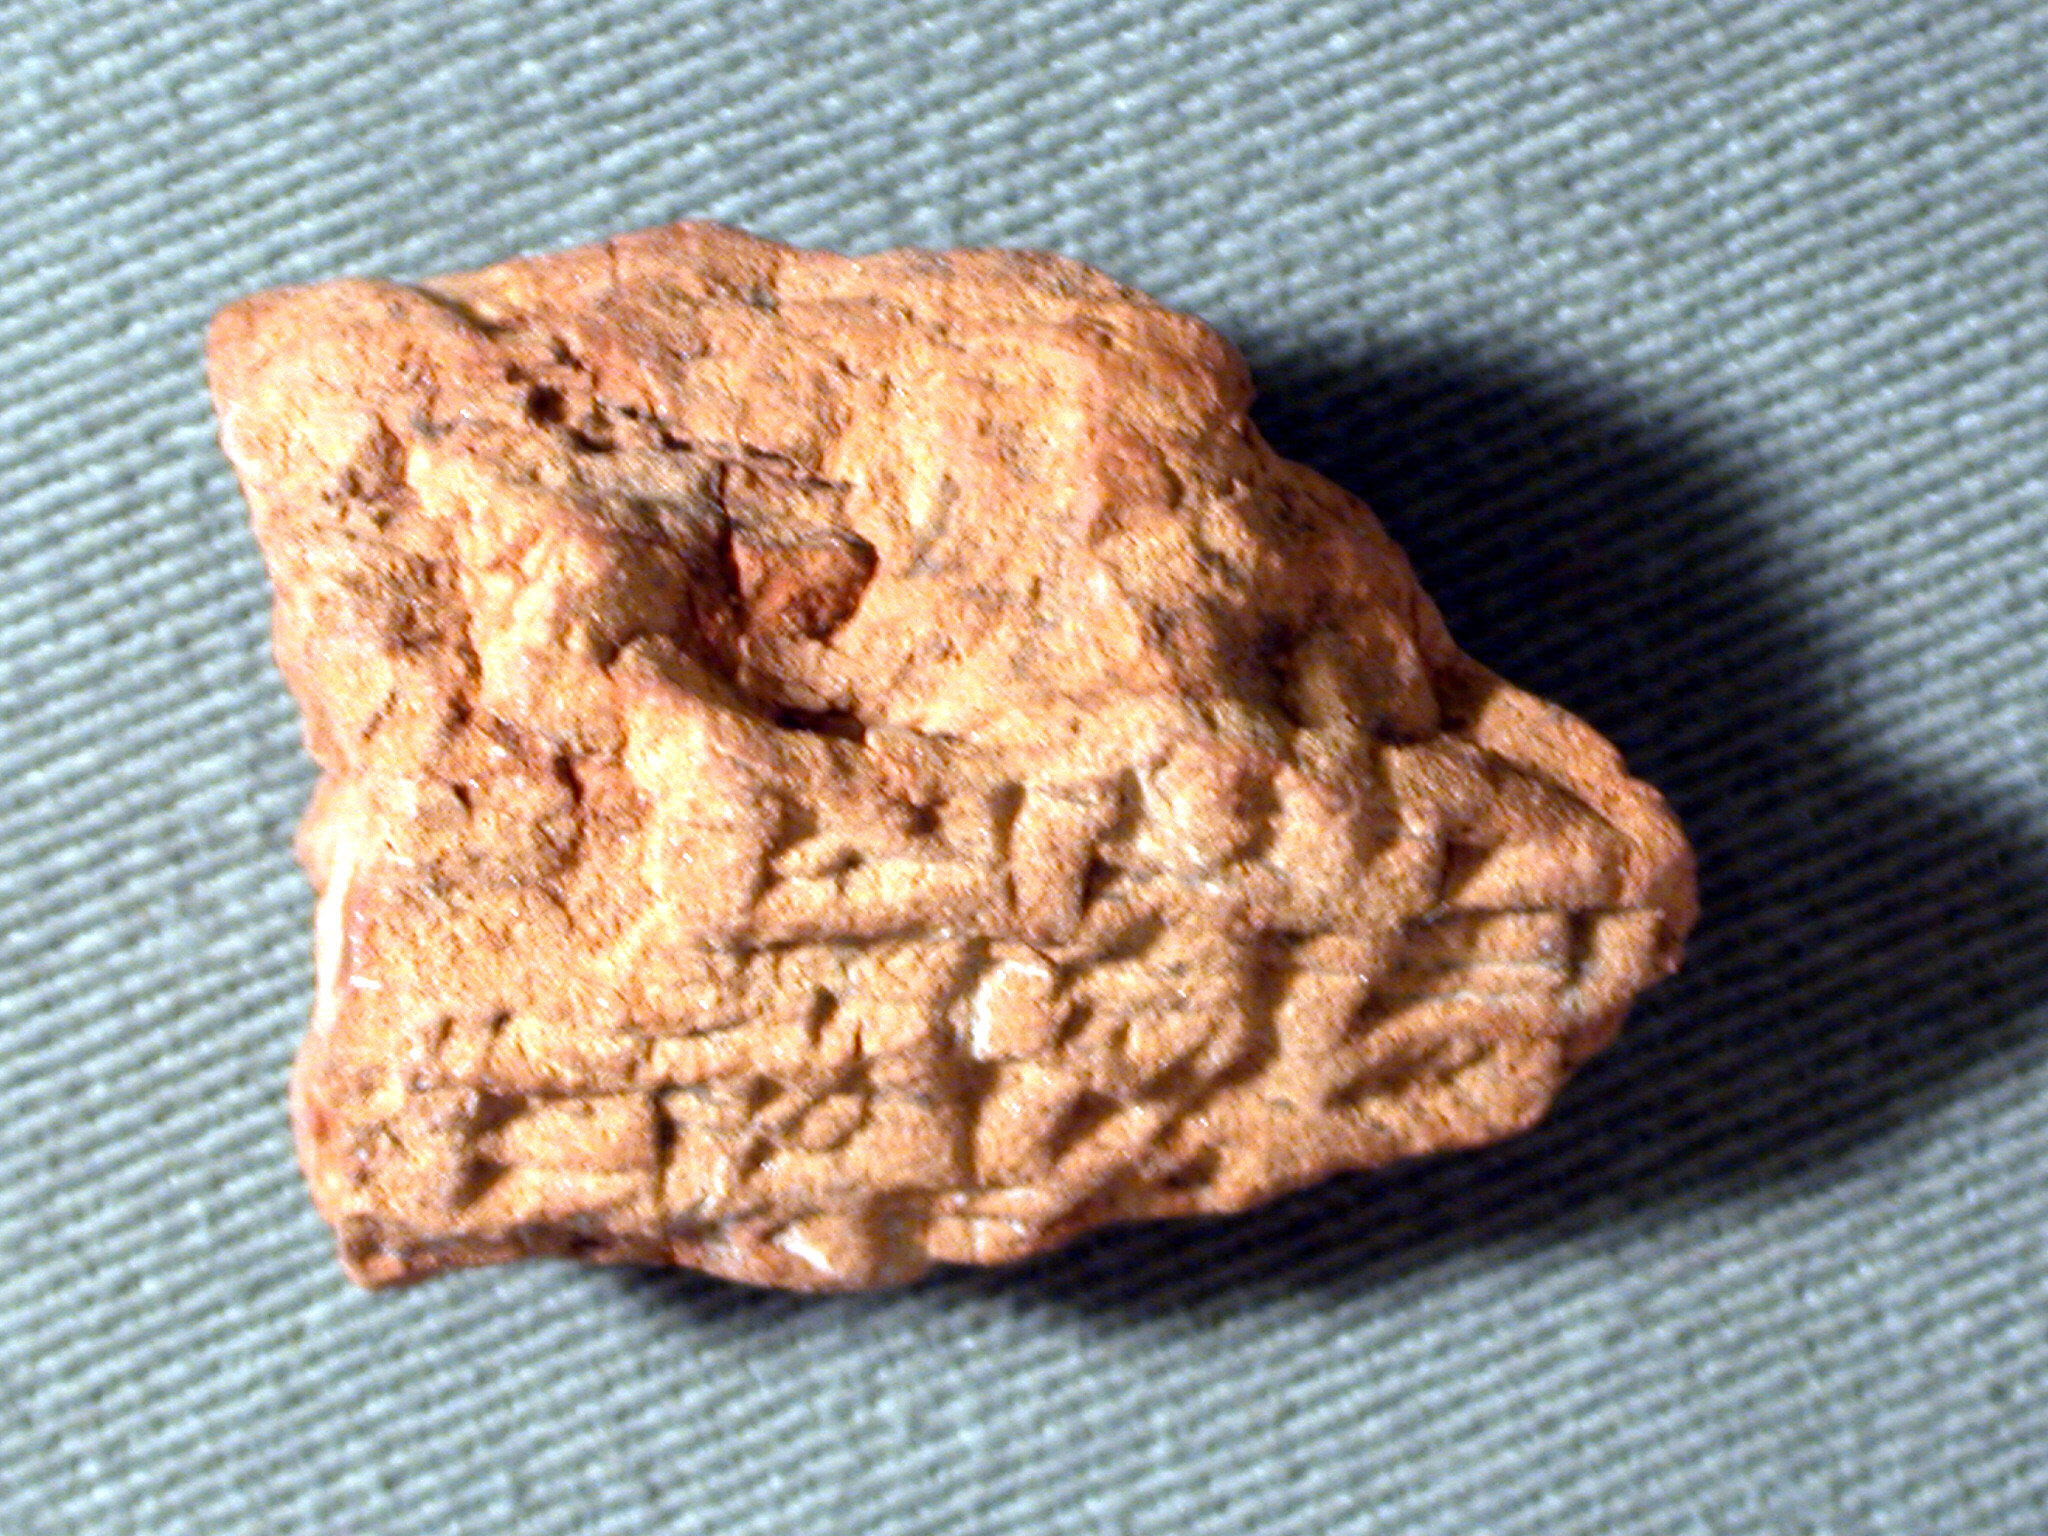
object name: cuneiform tablet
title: Cuneiform tablet: fragment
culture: babylonian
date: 568 BCE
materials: clay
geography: mesopotamia